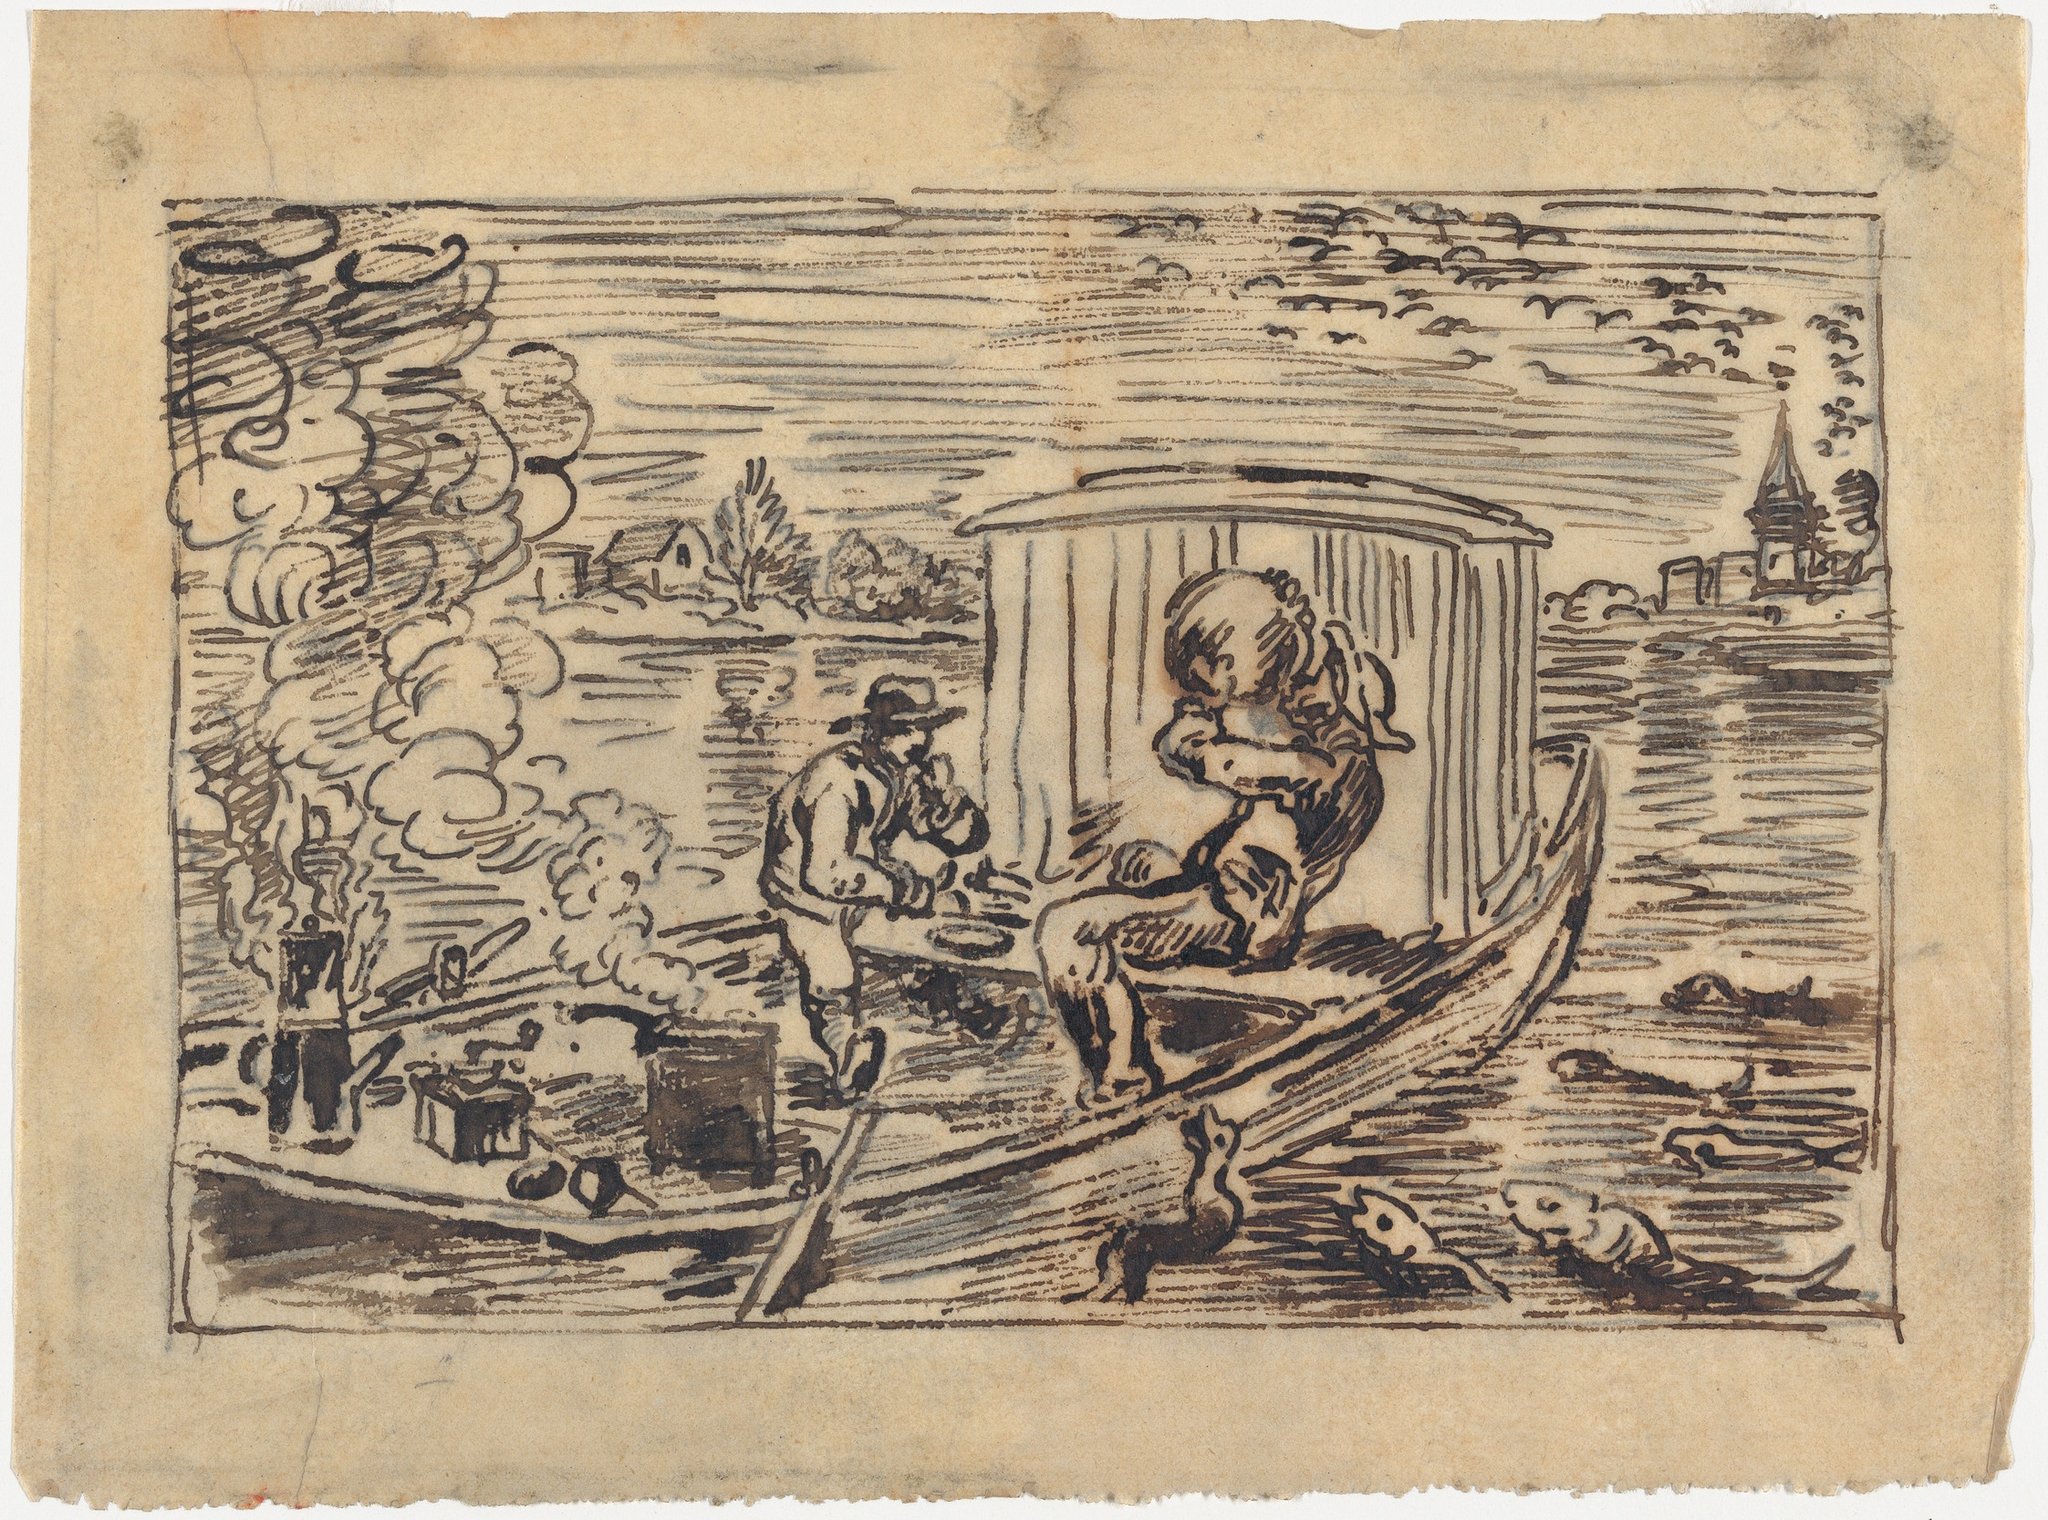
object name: drawing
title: Guzzling or Lunch on the Boat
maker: charles-françois daubigny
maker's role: artist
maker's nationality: french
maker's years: 1817-1878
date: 1862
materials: graphite, ink, paper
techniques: pen